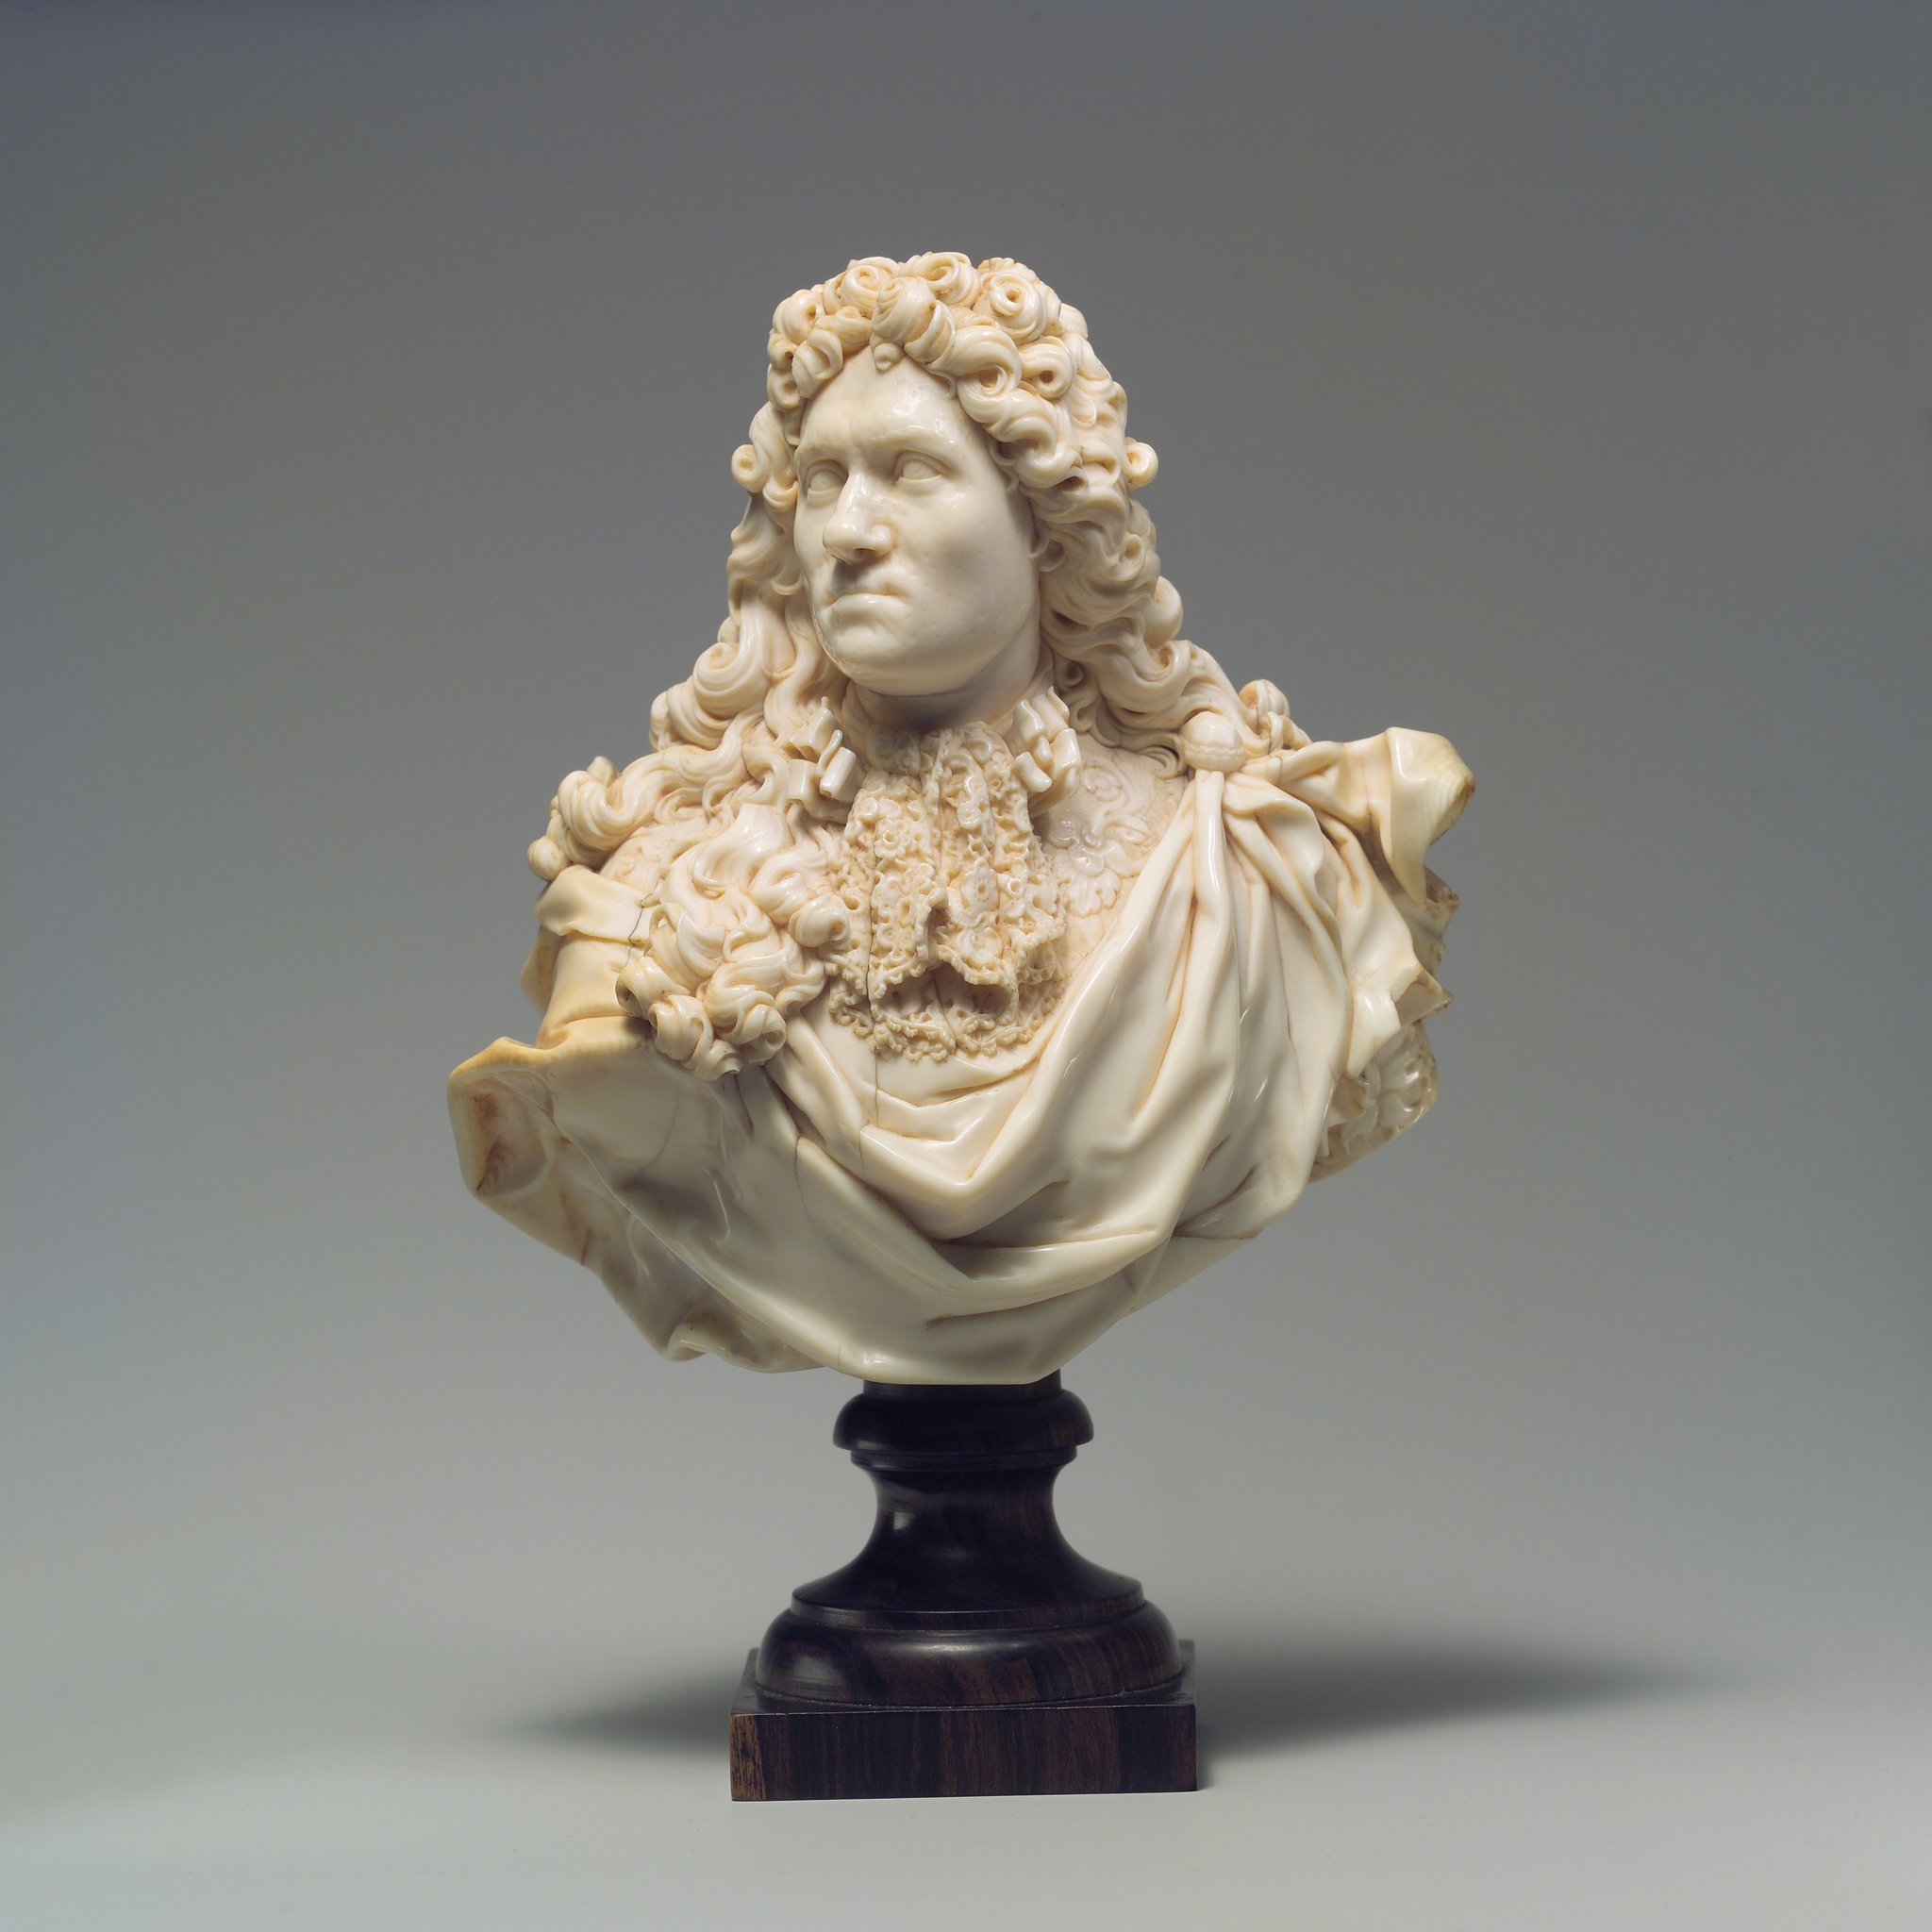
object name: bust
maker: c. lacroix, franco-flemish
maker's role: maker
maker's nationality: franco-flemish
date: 1695-1700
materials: ivory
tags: men,portraits